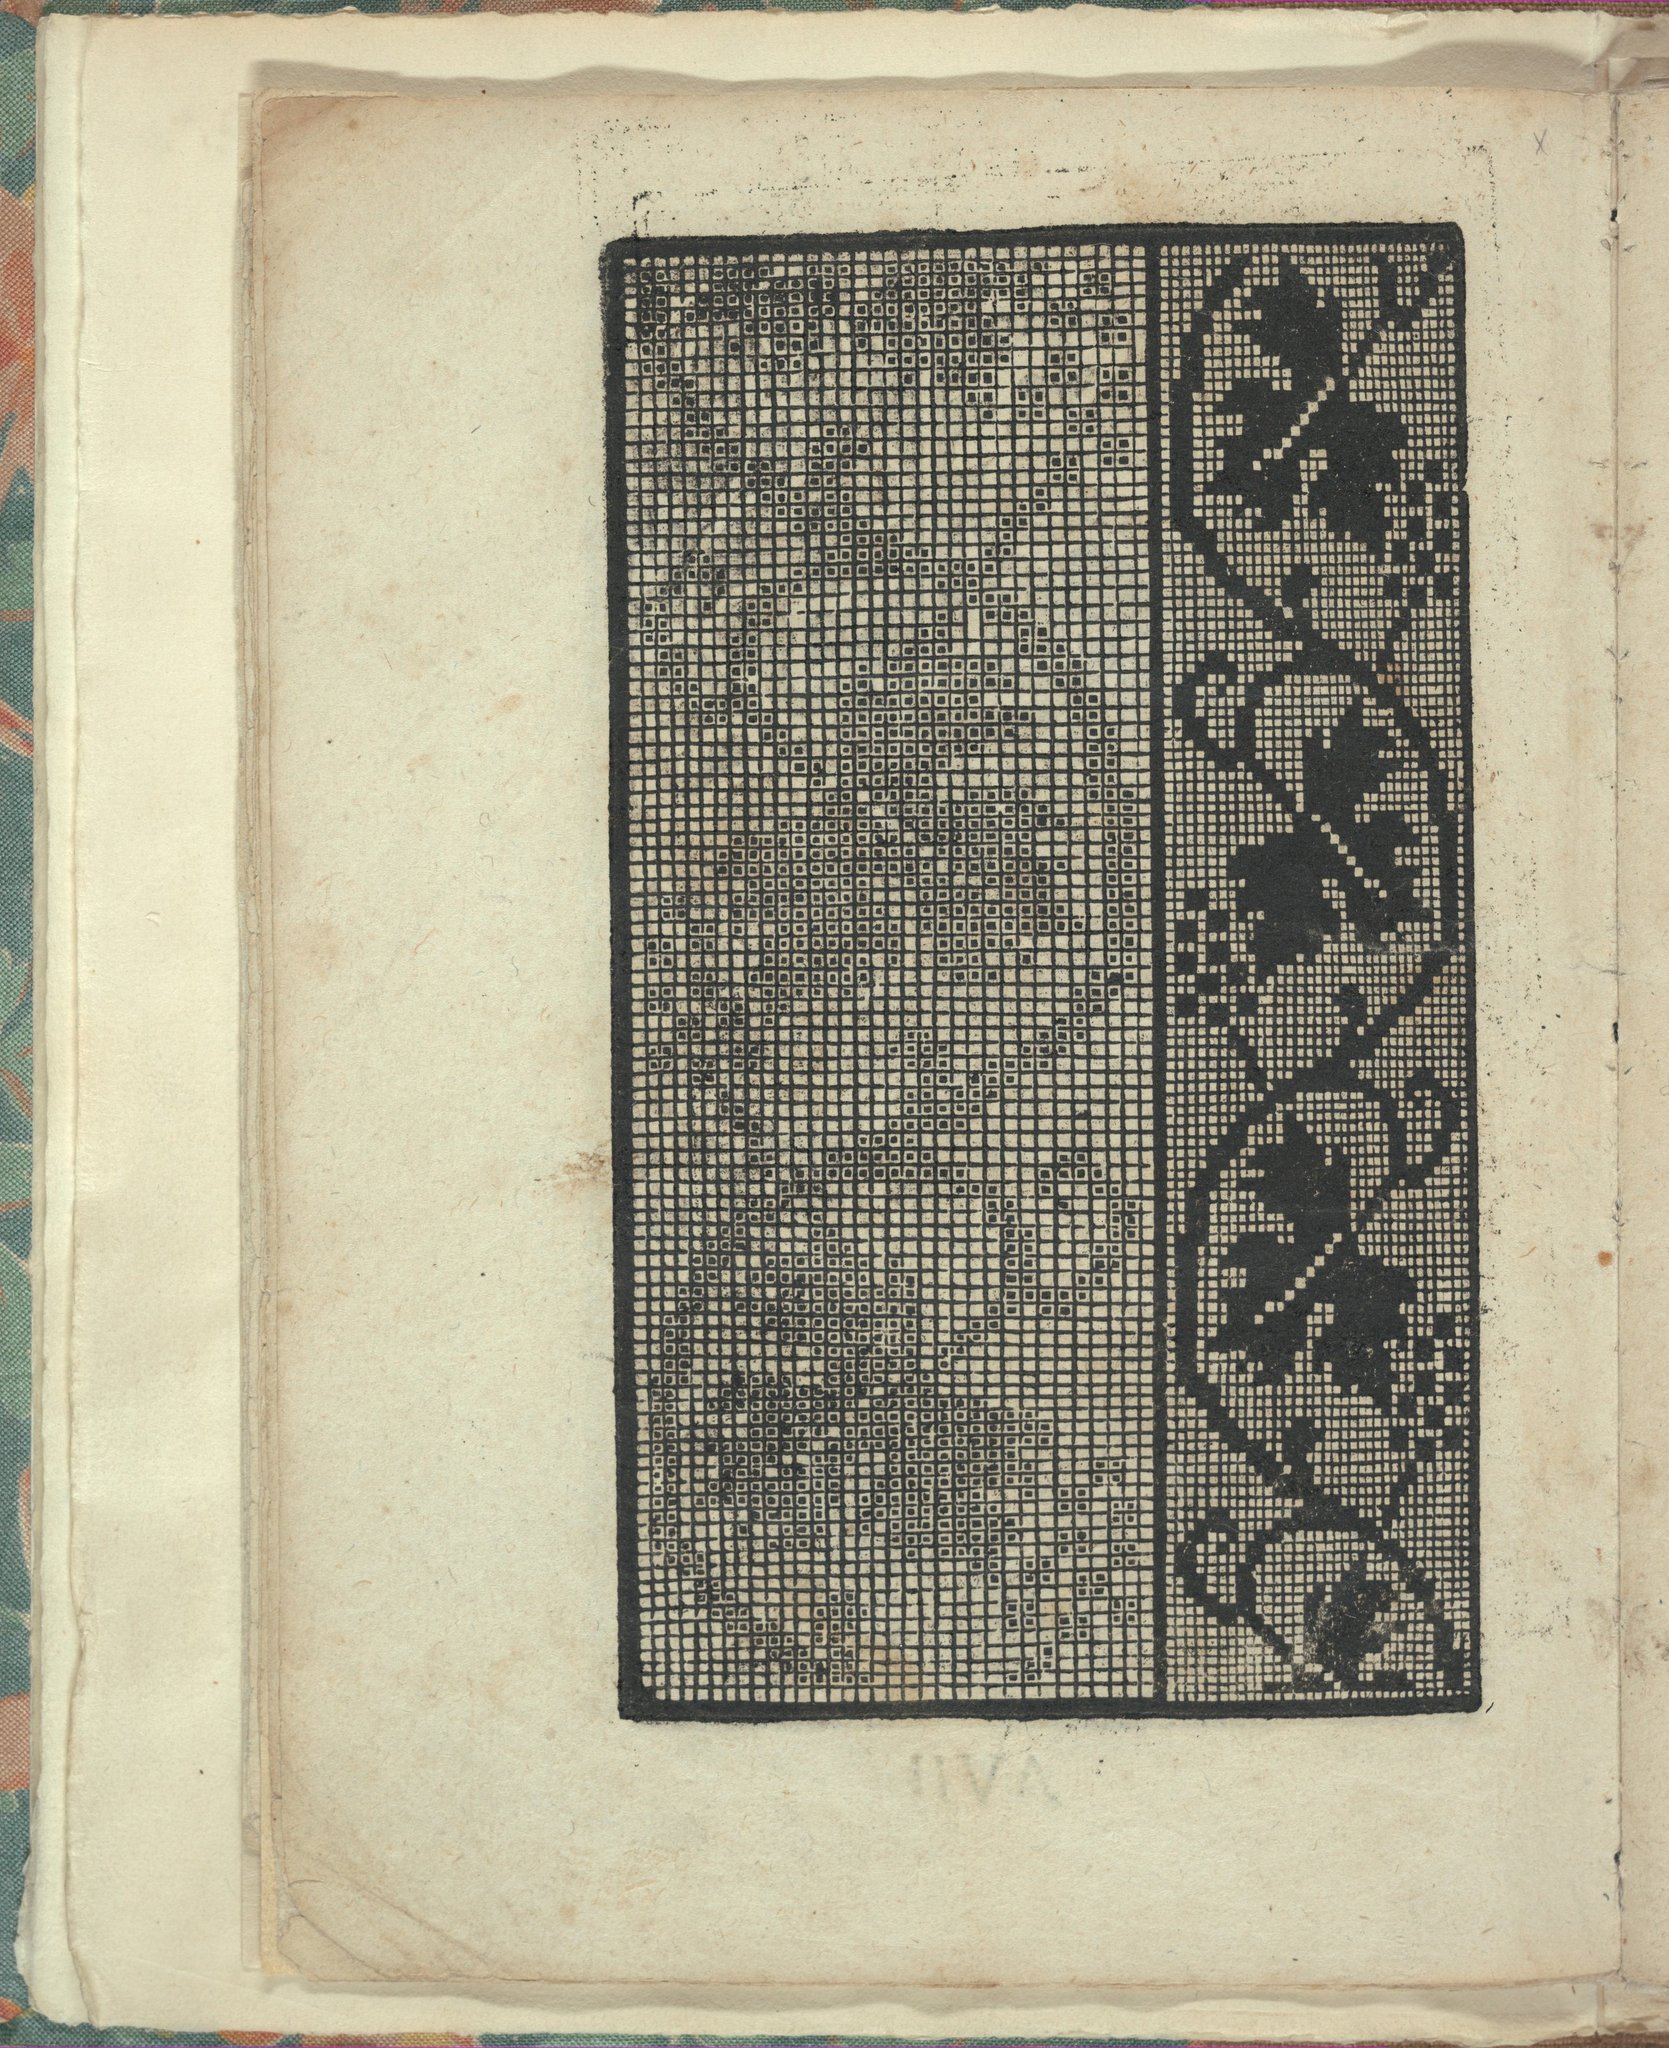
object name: book print ornament architecture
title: Opera Nova Universali intitulata Corona di racammi, page 7 (verso)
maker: giovanni andrea vavassore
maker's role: publisher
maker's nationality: italian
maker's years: 1530-1573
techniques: woodcut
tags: grapes,leaves,vines